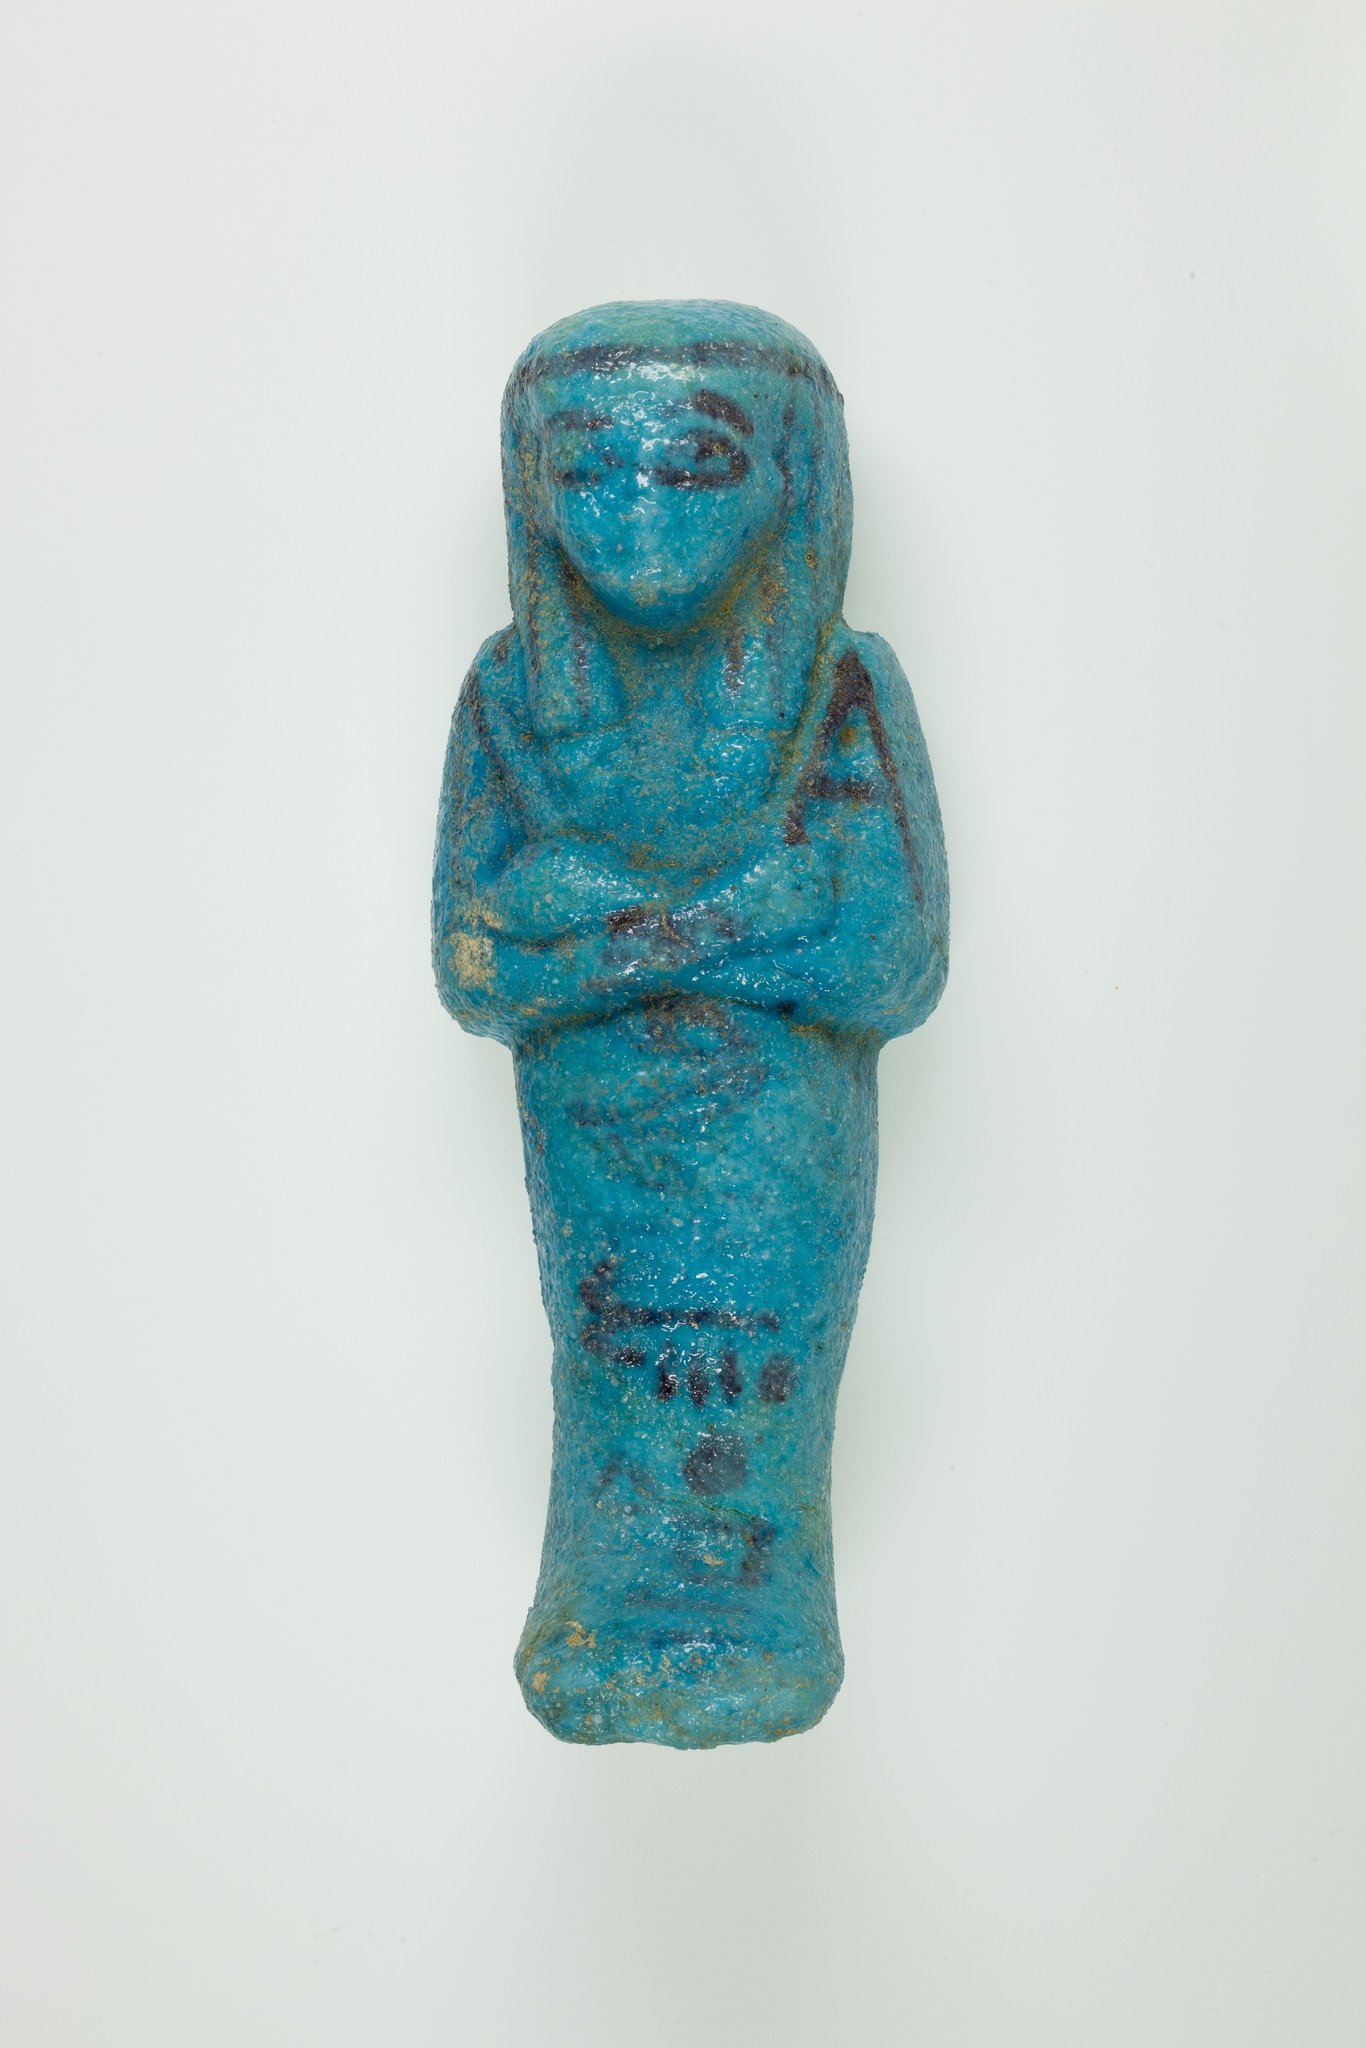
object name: worker shabti, henettawy c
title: Worker Shabti of Henettawy (C), Daughter of Isetemkheb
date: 990-970 BCE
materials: faience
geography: egypt